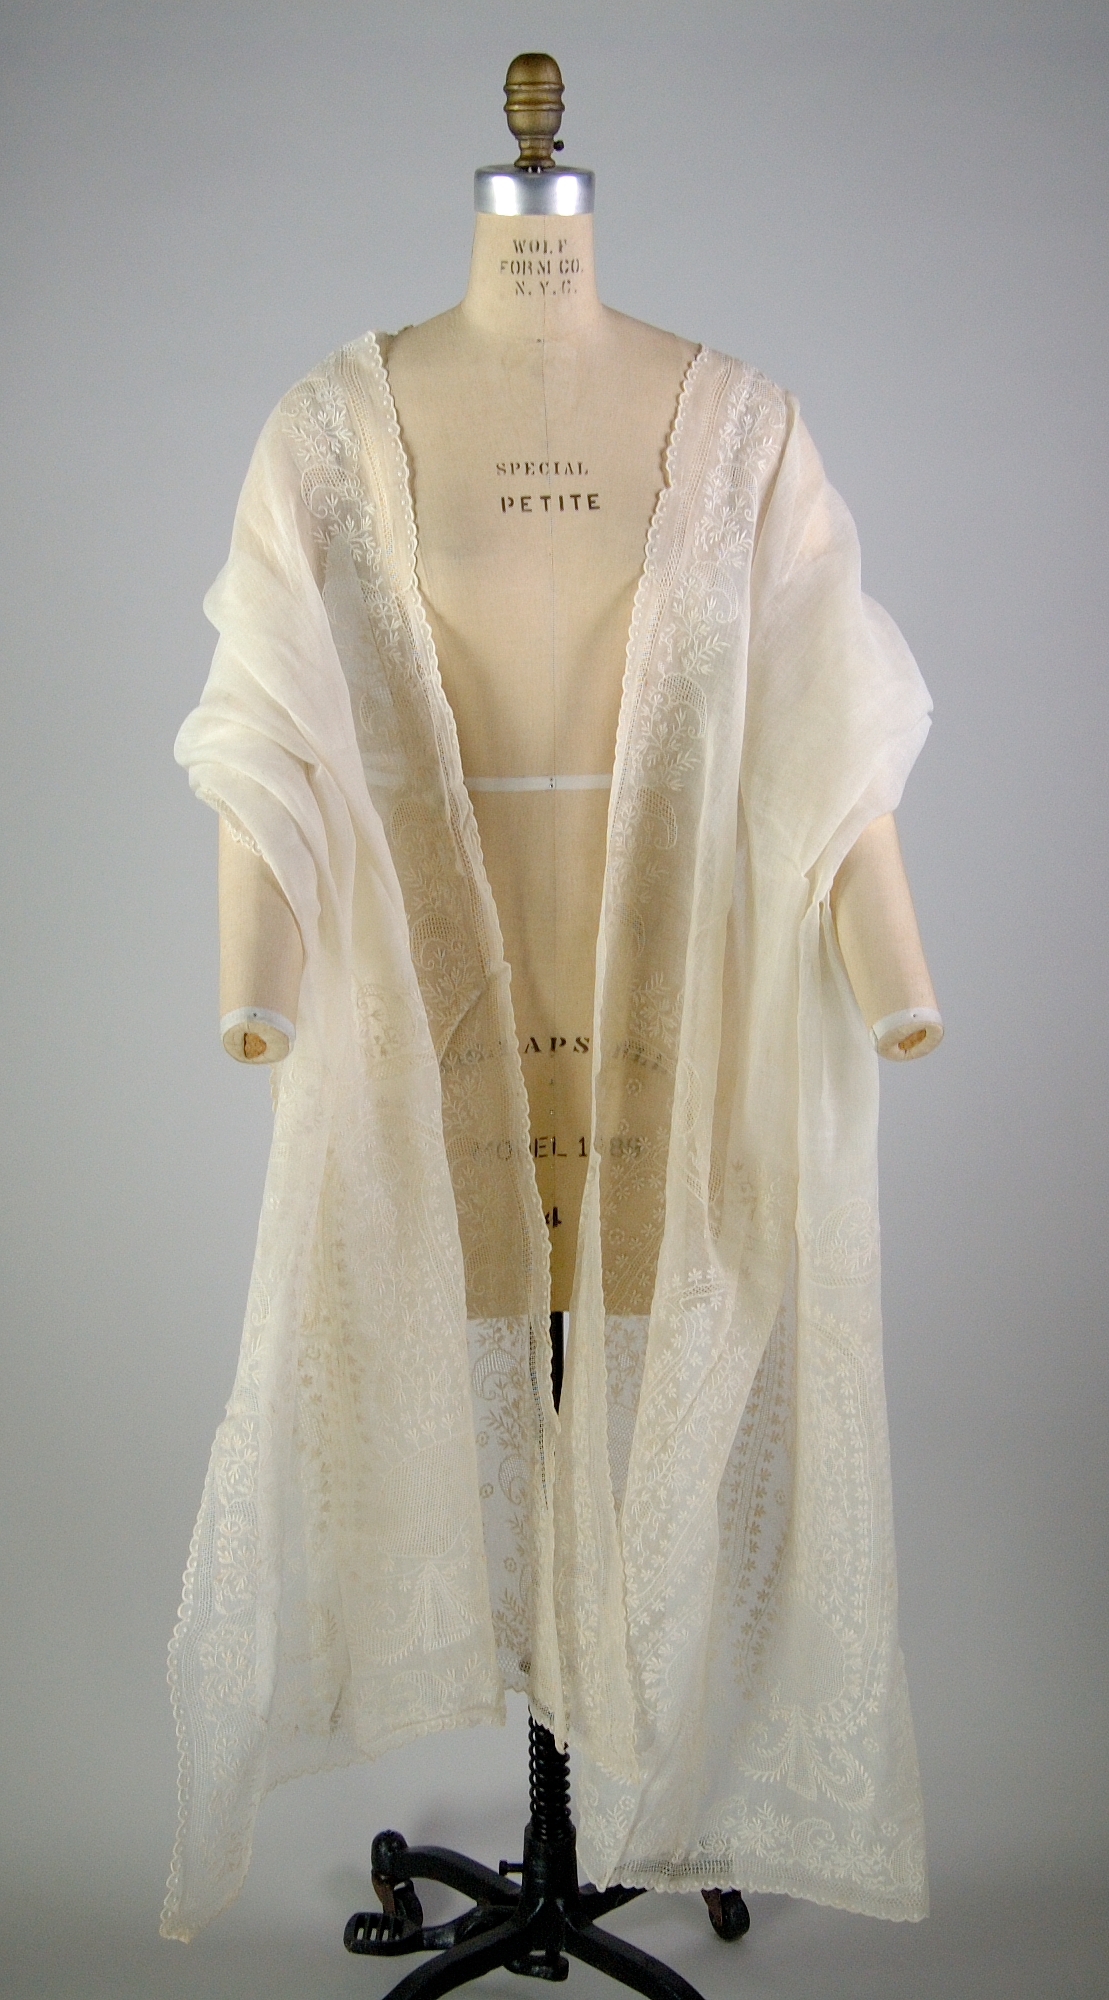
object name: stole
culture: american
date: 1820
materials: cotton